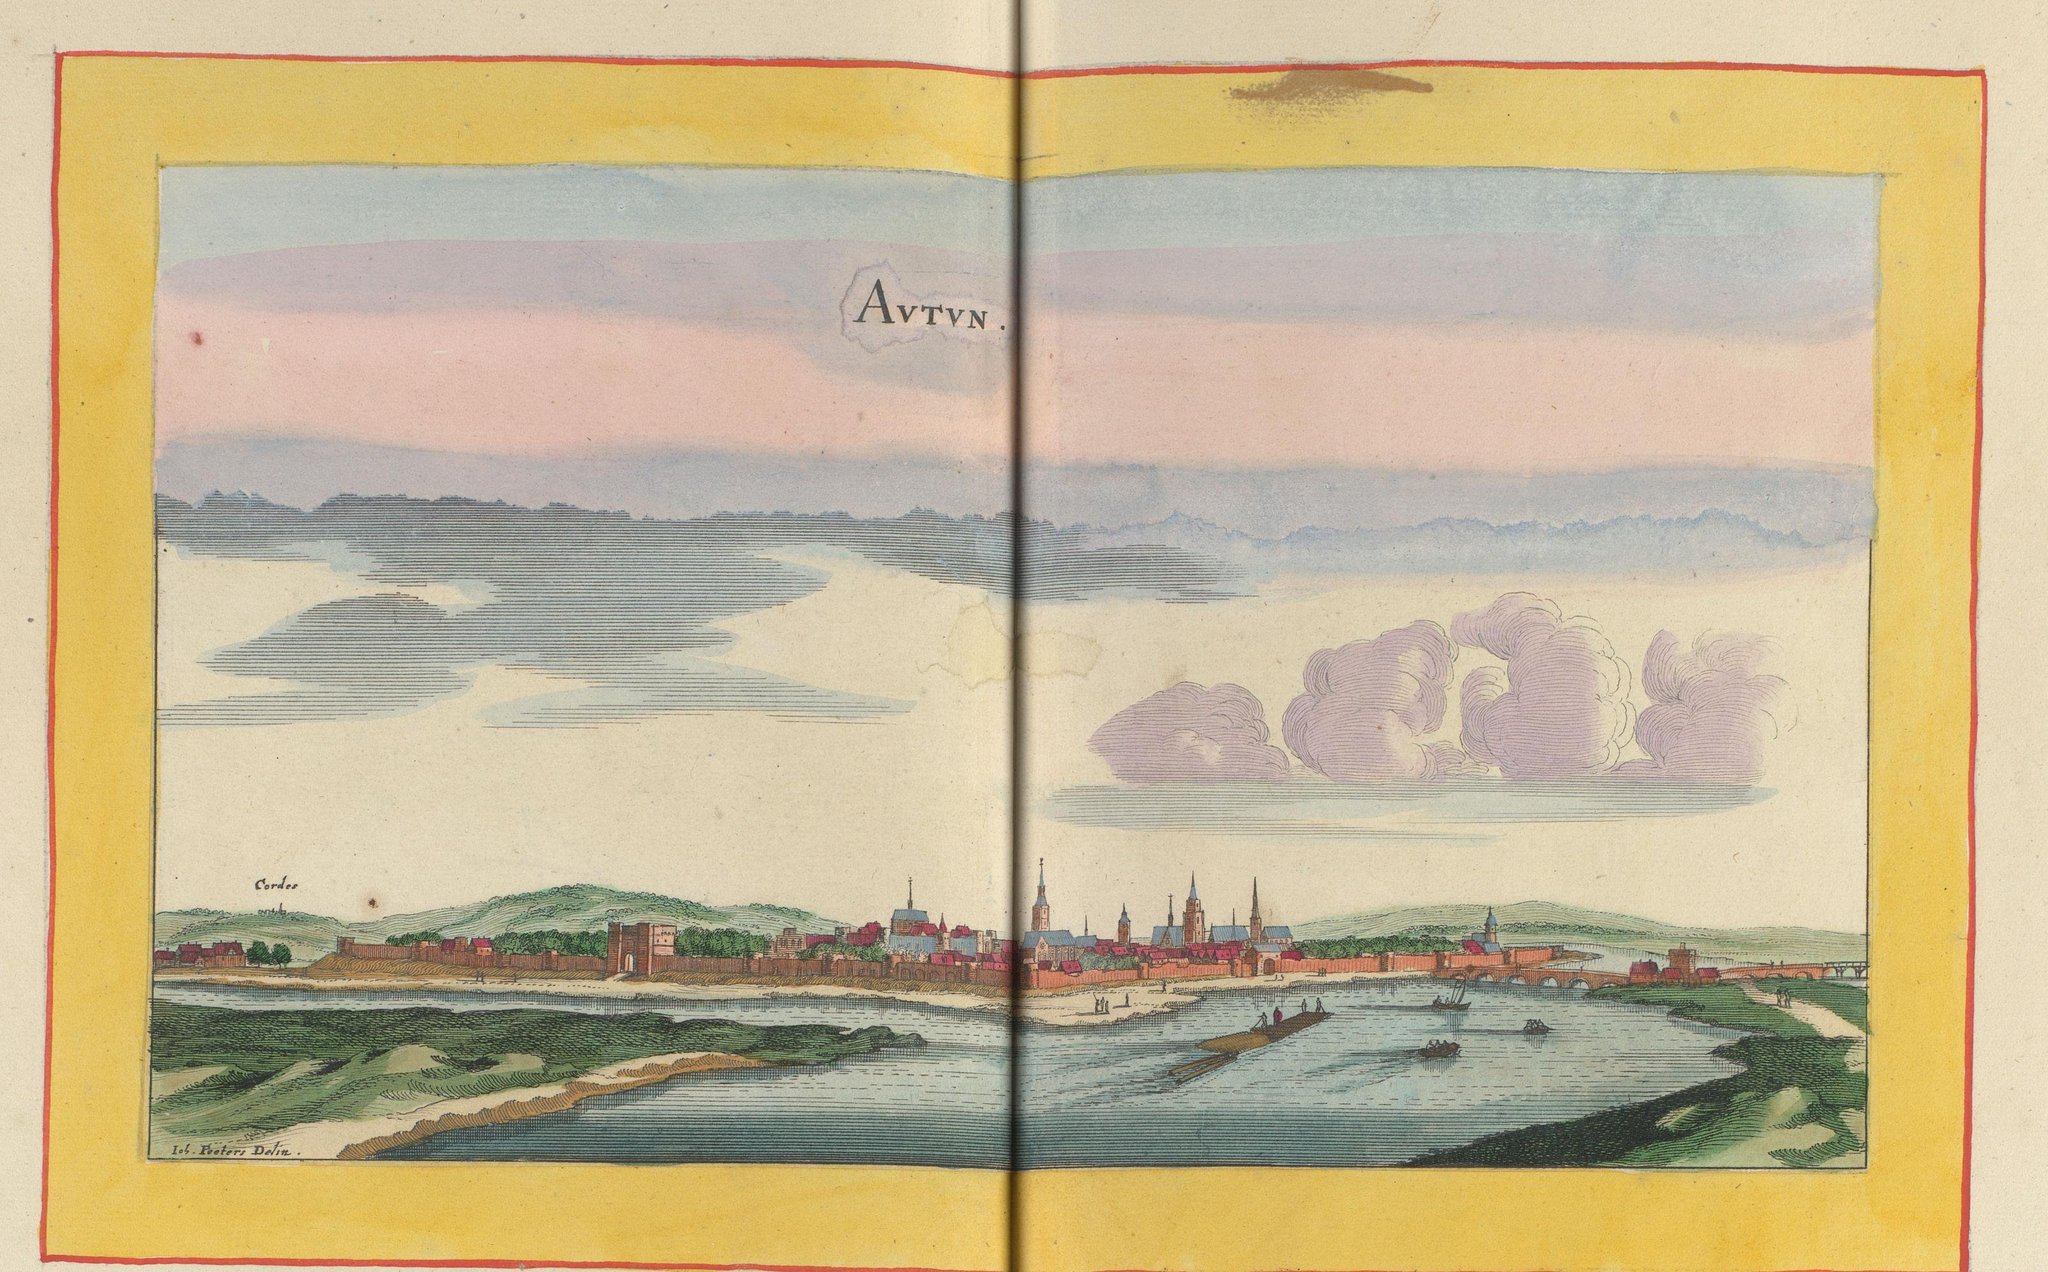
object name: print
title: Gezicht op Autun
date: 1656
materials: paper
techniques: engraving, etching, hand coloring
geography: the hague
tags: city-view in general; 'veduta'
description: Prent uit: Zeiller, Martin. Topographia Galliae. 13 dln. Frankfurt: Caspar Merian, 1656, dl. 4, na p. 6. De titel is uit de originele prent gesneden. Boven de gravure is een deel lucht en wolken (bij)geschilderd, waarin de titel gelijmd is. Origineel op één blad gedrukt met een gezicht op Auxonne (RP-P-1957-607-54-2).